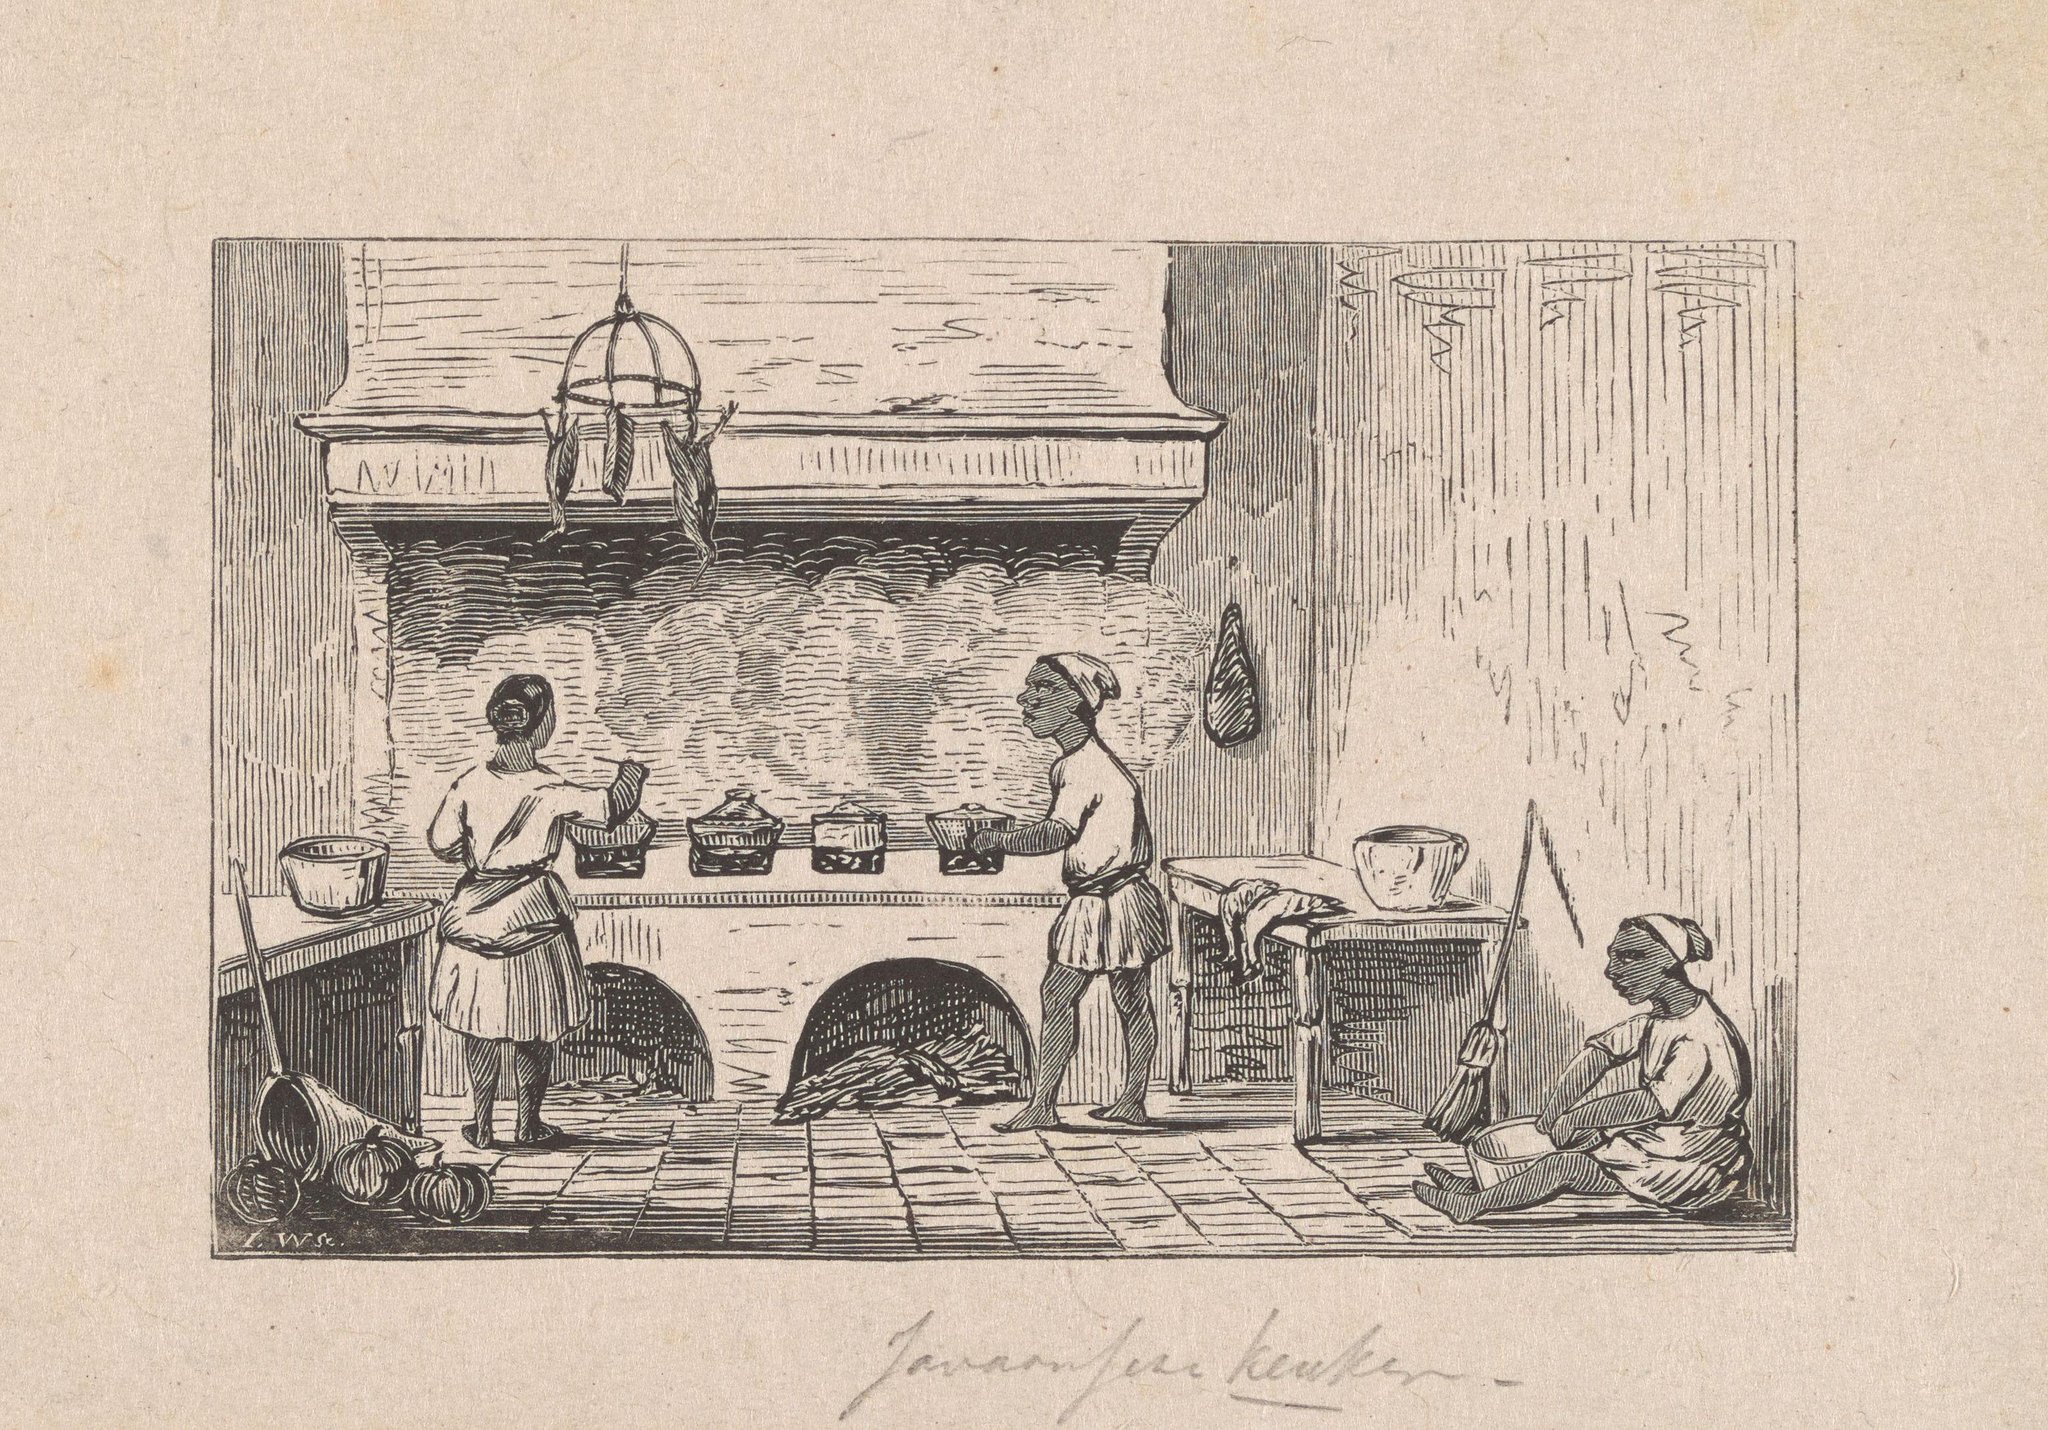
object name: print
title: Interieur van een Javaanse keuken met twee mannen en een vrouw aan het werk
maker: isaac weissenbruch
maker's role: print maker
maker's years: 1826-1912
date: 1836-1912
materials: paper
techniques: engraving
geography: netherlands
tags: adult woman, adult man, kitchen-interior